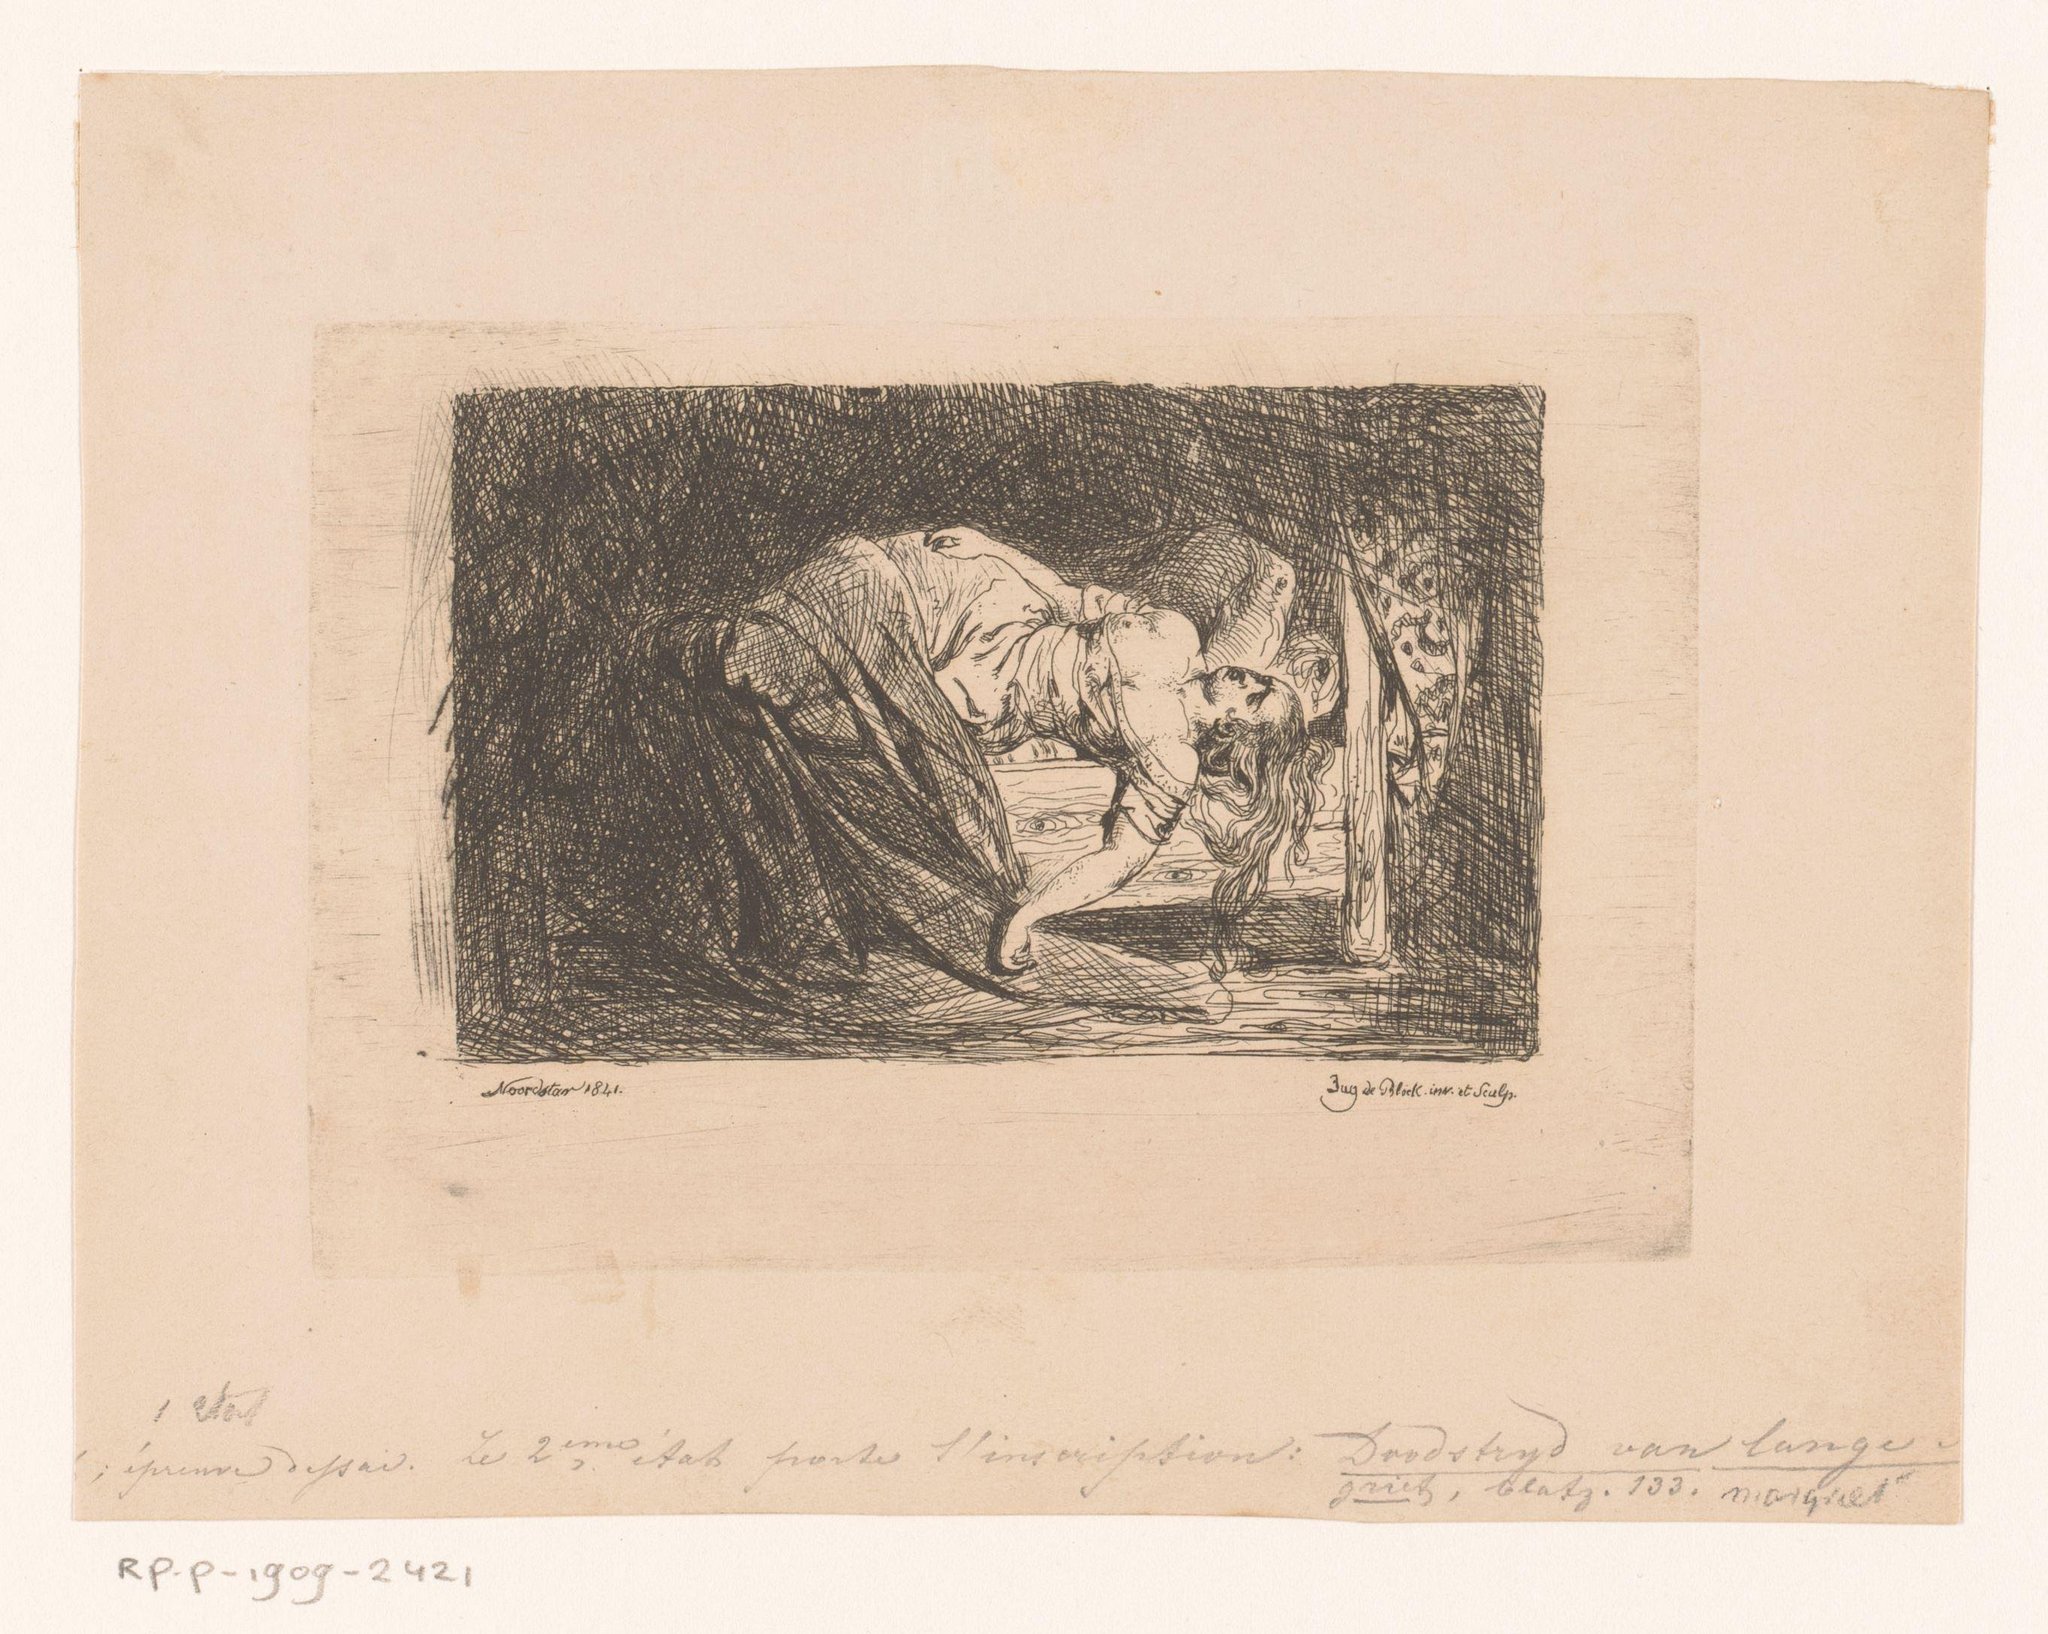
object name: print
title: Doodstrijd van lange Margriet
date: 1841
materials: paper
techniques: etching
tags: adult woman, sick-bed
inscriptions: collector's mark: Lugt 2228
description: Prent uit: De Noordstar, 2 (1841). De prent toont een scène uit het verhaal 'Fabricius en lange Margriet' van P.F. van Kerckhoven.